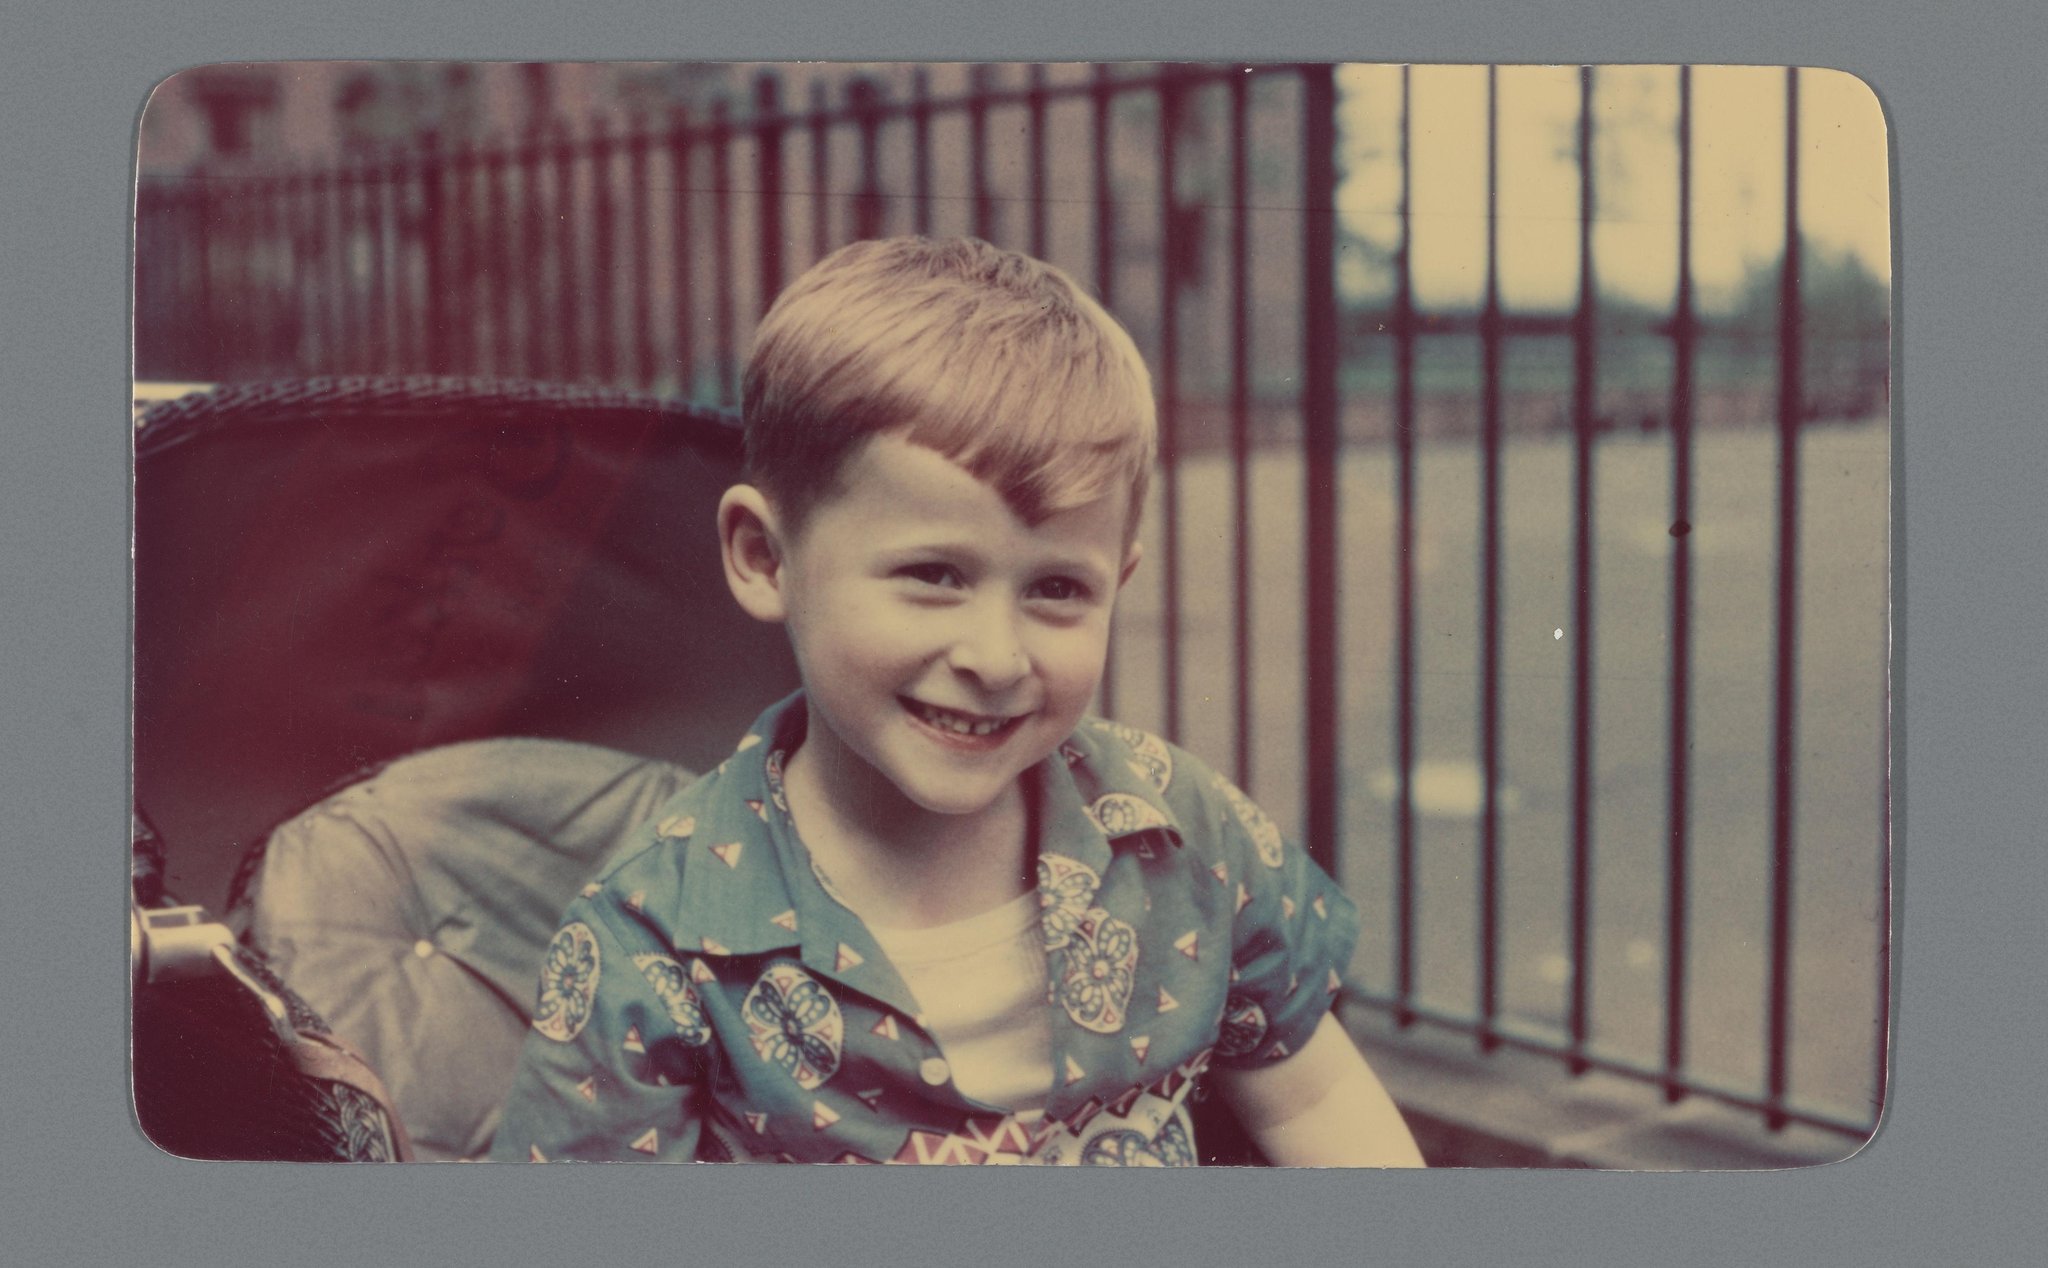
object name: photograph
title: Portret van een jongetje buiten bij hek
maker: Anonymous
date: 1948-1955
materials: photographic support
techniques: chromogenic print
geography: united states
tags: united states of america